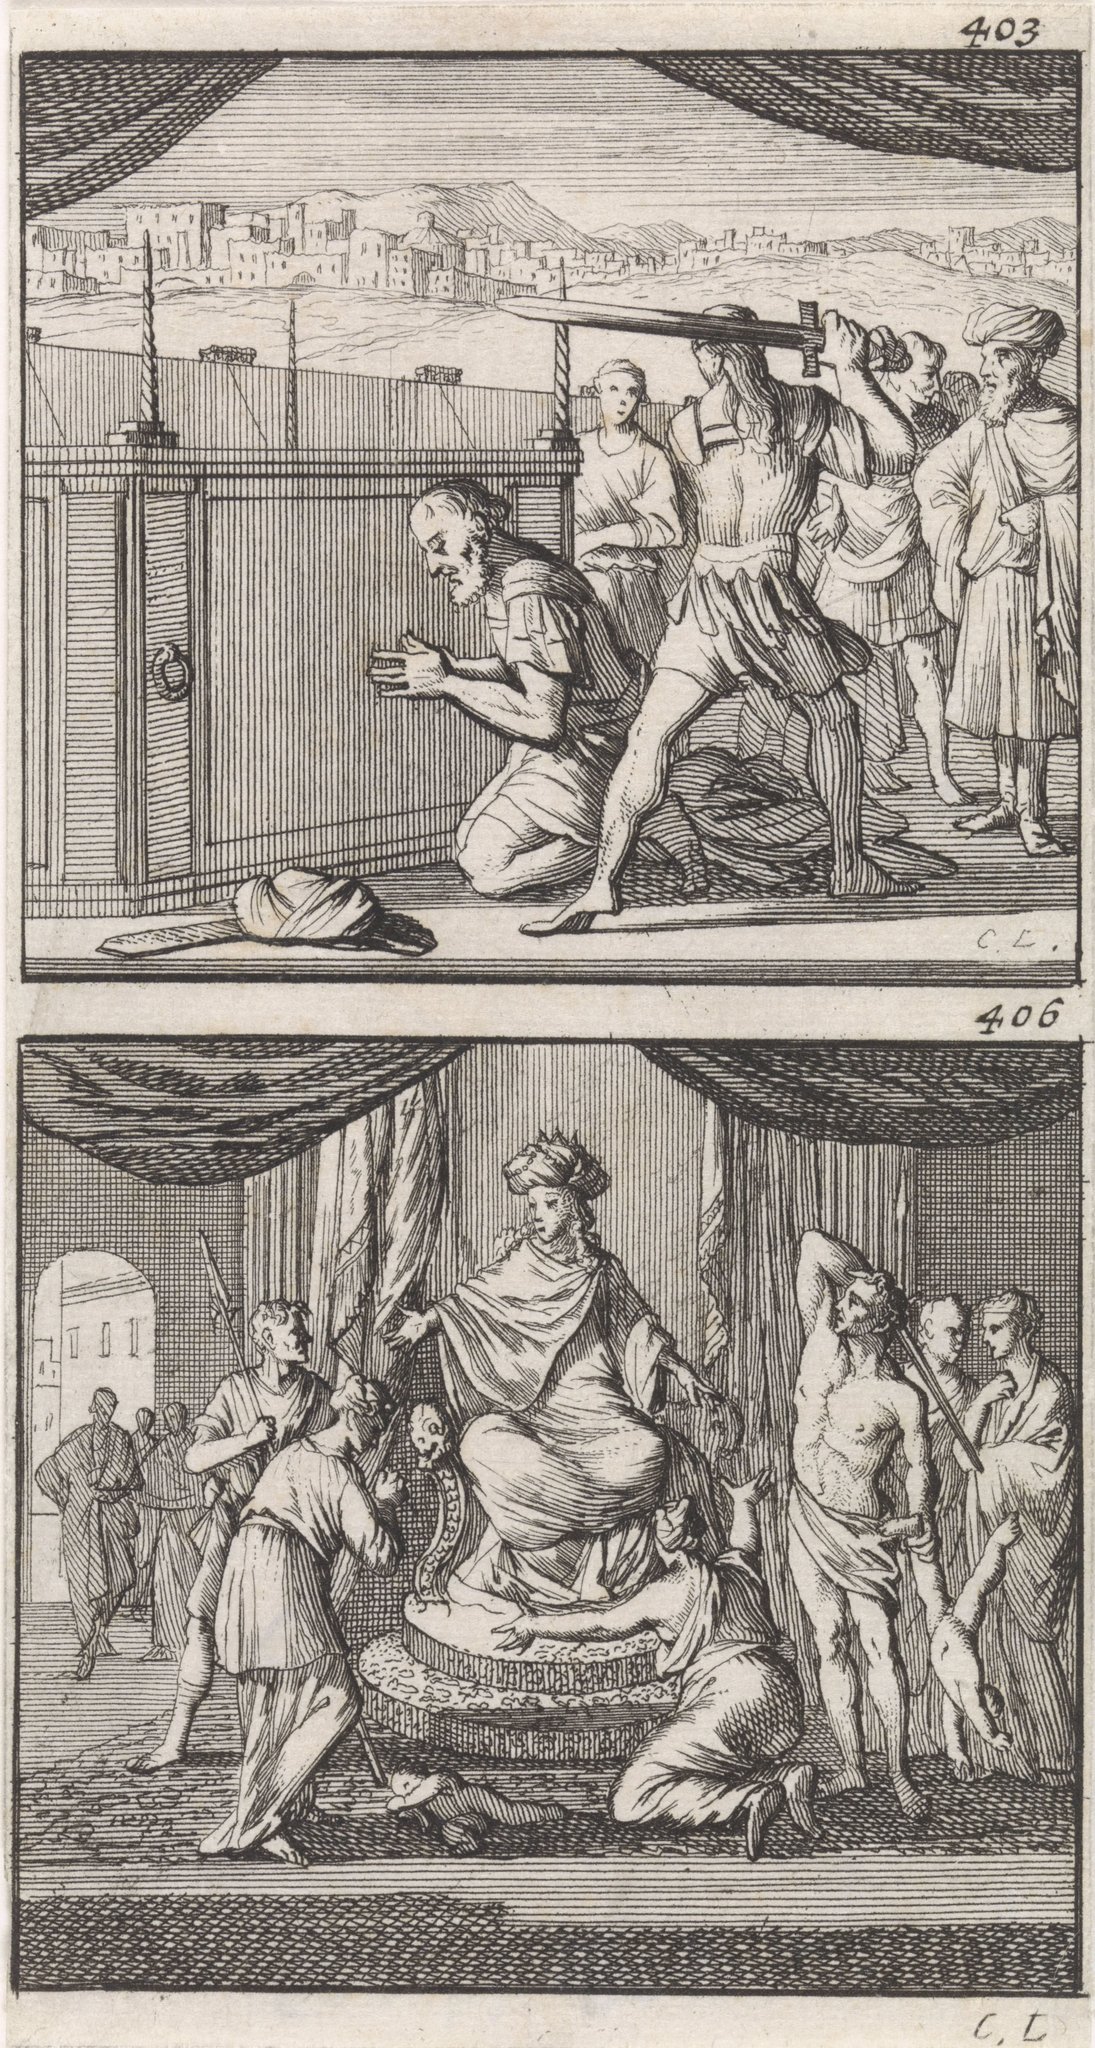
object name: book illustration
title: Onthoofding van Joab / Salomo's rechtspraak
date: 1698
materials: paper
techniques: etching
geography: amsterdam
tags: the judgement of solomon (1 kings 3:16-28), joab killed by benaiah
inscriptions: collector's mark: Lugt 2228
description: Illustratie uit: Josephus, Flavius. XX. boeken van de oude geschiedenissen der joden, 4 delen. Amsterdam: Barent Visscher, Willem de Coup, Willem van Lamsveld, Andries van Damme, 1698, dl. I.